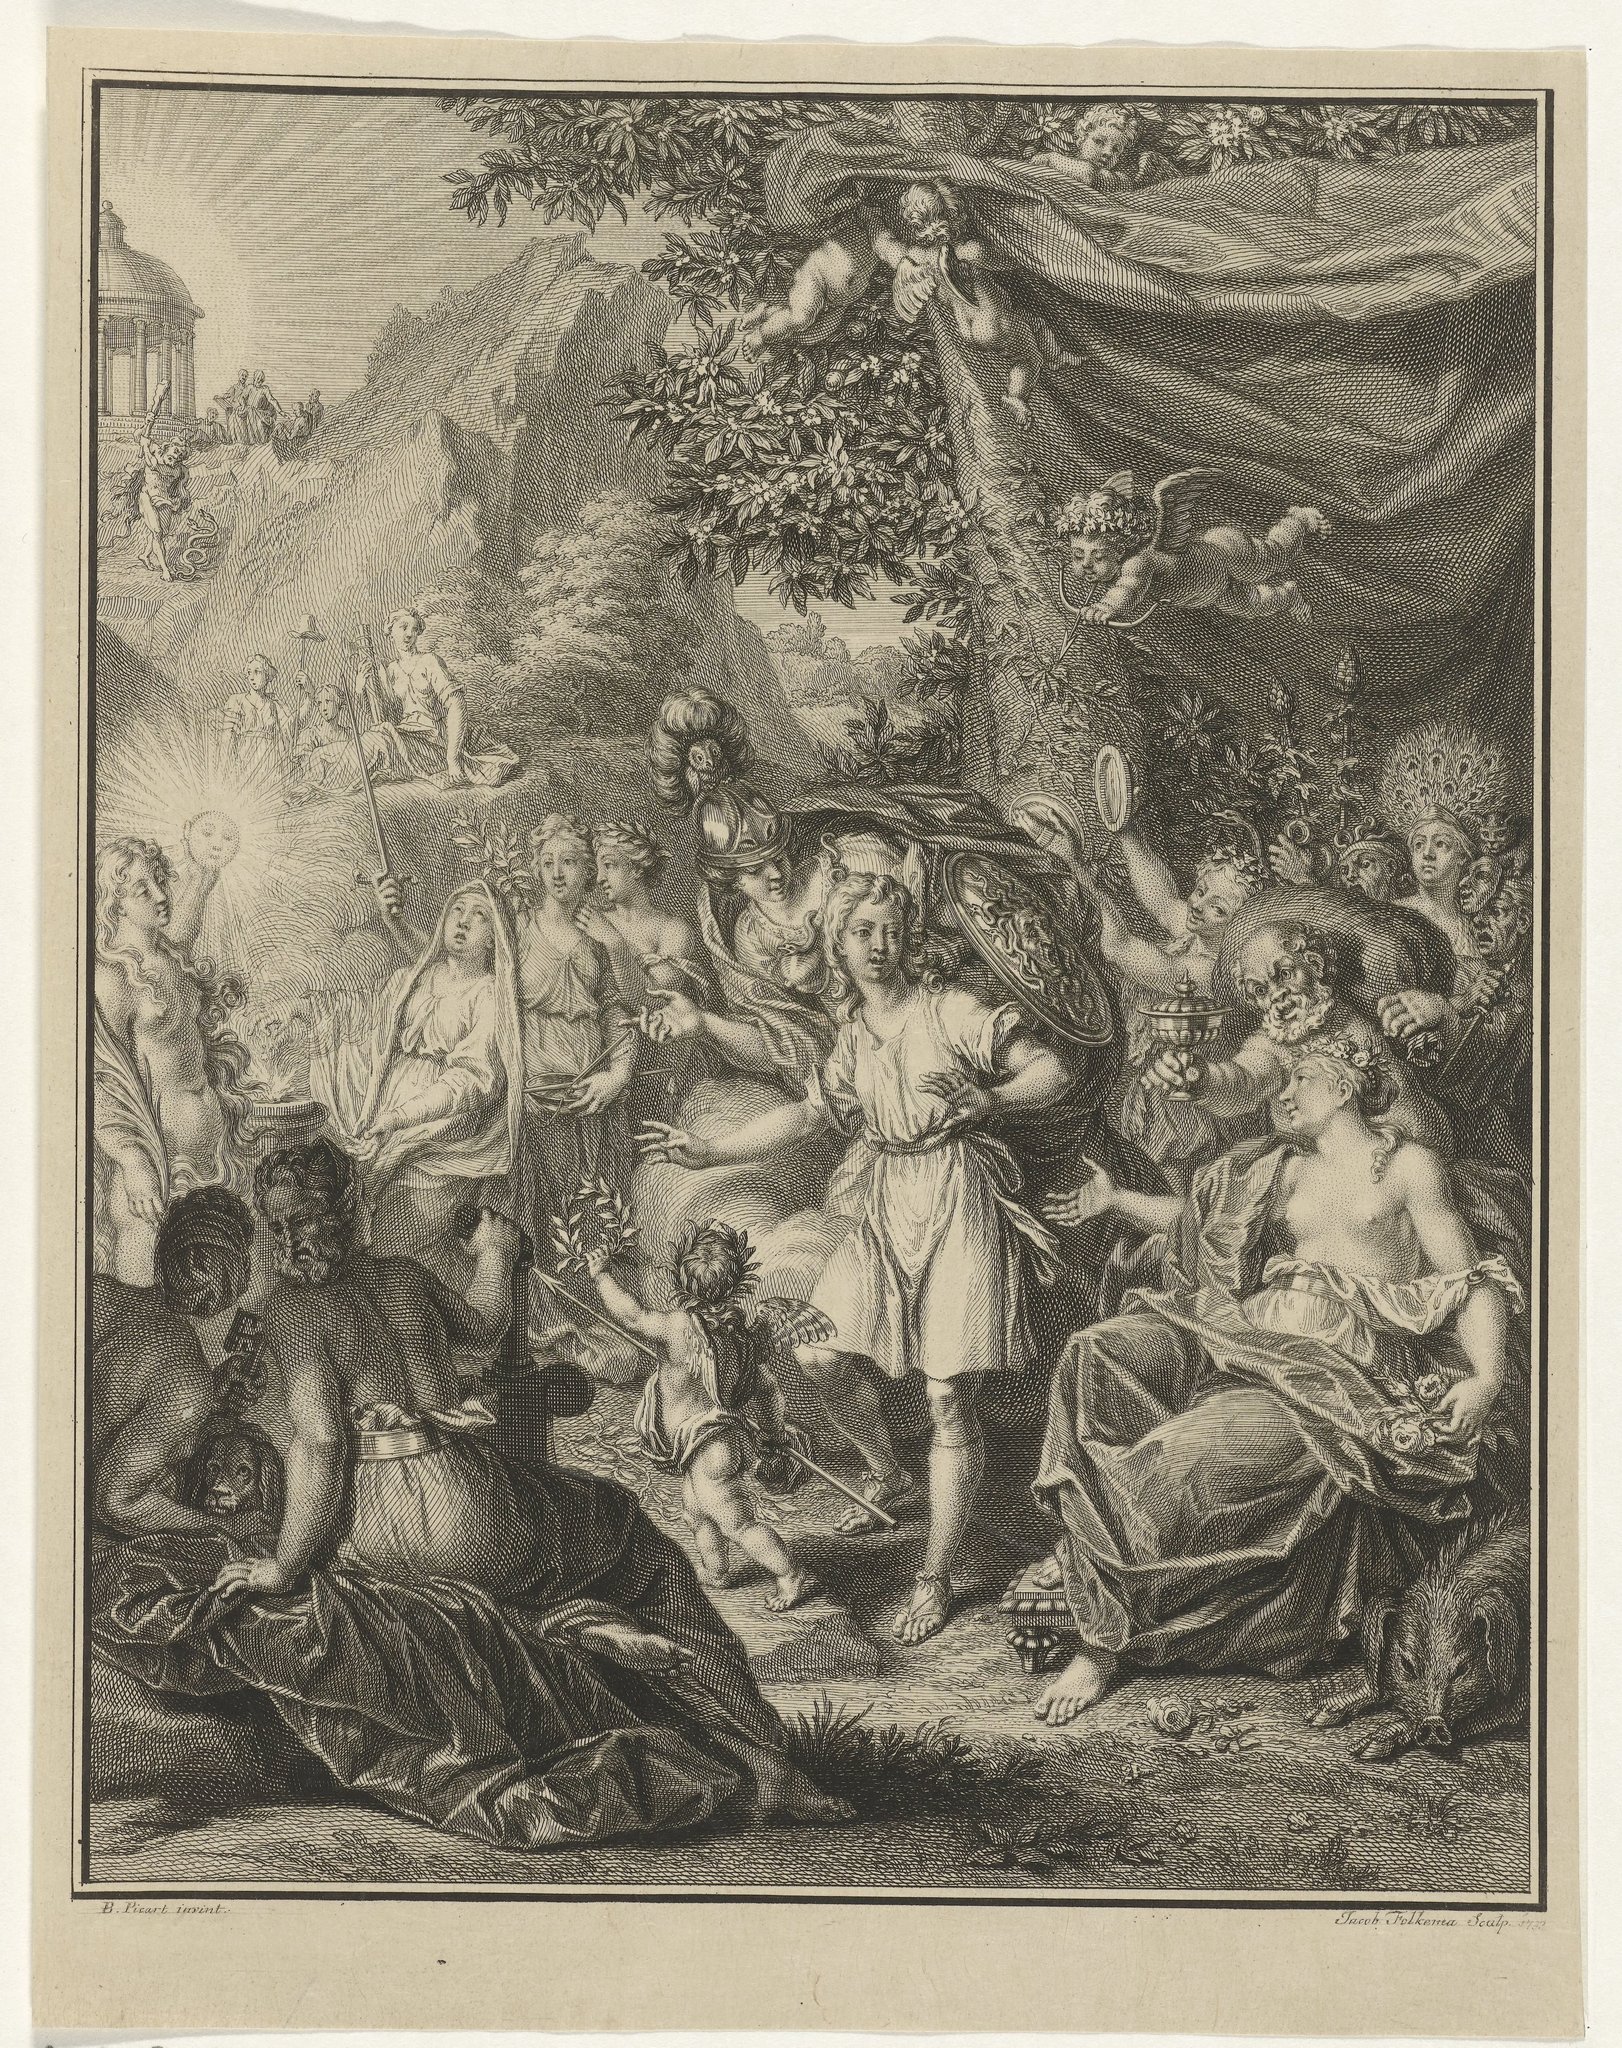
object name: print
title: Allegorische voorstelling met Telemachus en Minerva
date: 1733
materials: paper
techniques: etching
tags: (story of) minerva (pallas, athena), (story of) telemachus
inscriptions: collector's mark: Lugt 240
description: Telemachus wordt begeleid door Minerva die hem wijst op de talloze allegorische figuren die hen omringen. Illustratie vervaardigd bij een verhaal uit "Avonturen van Telemachus", geschreven door François de Fénélon.